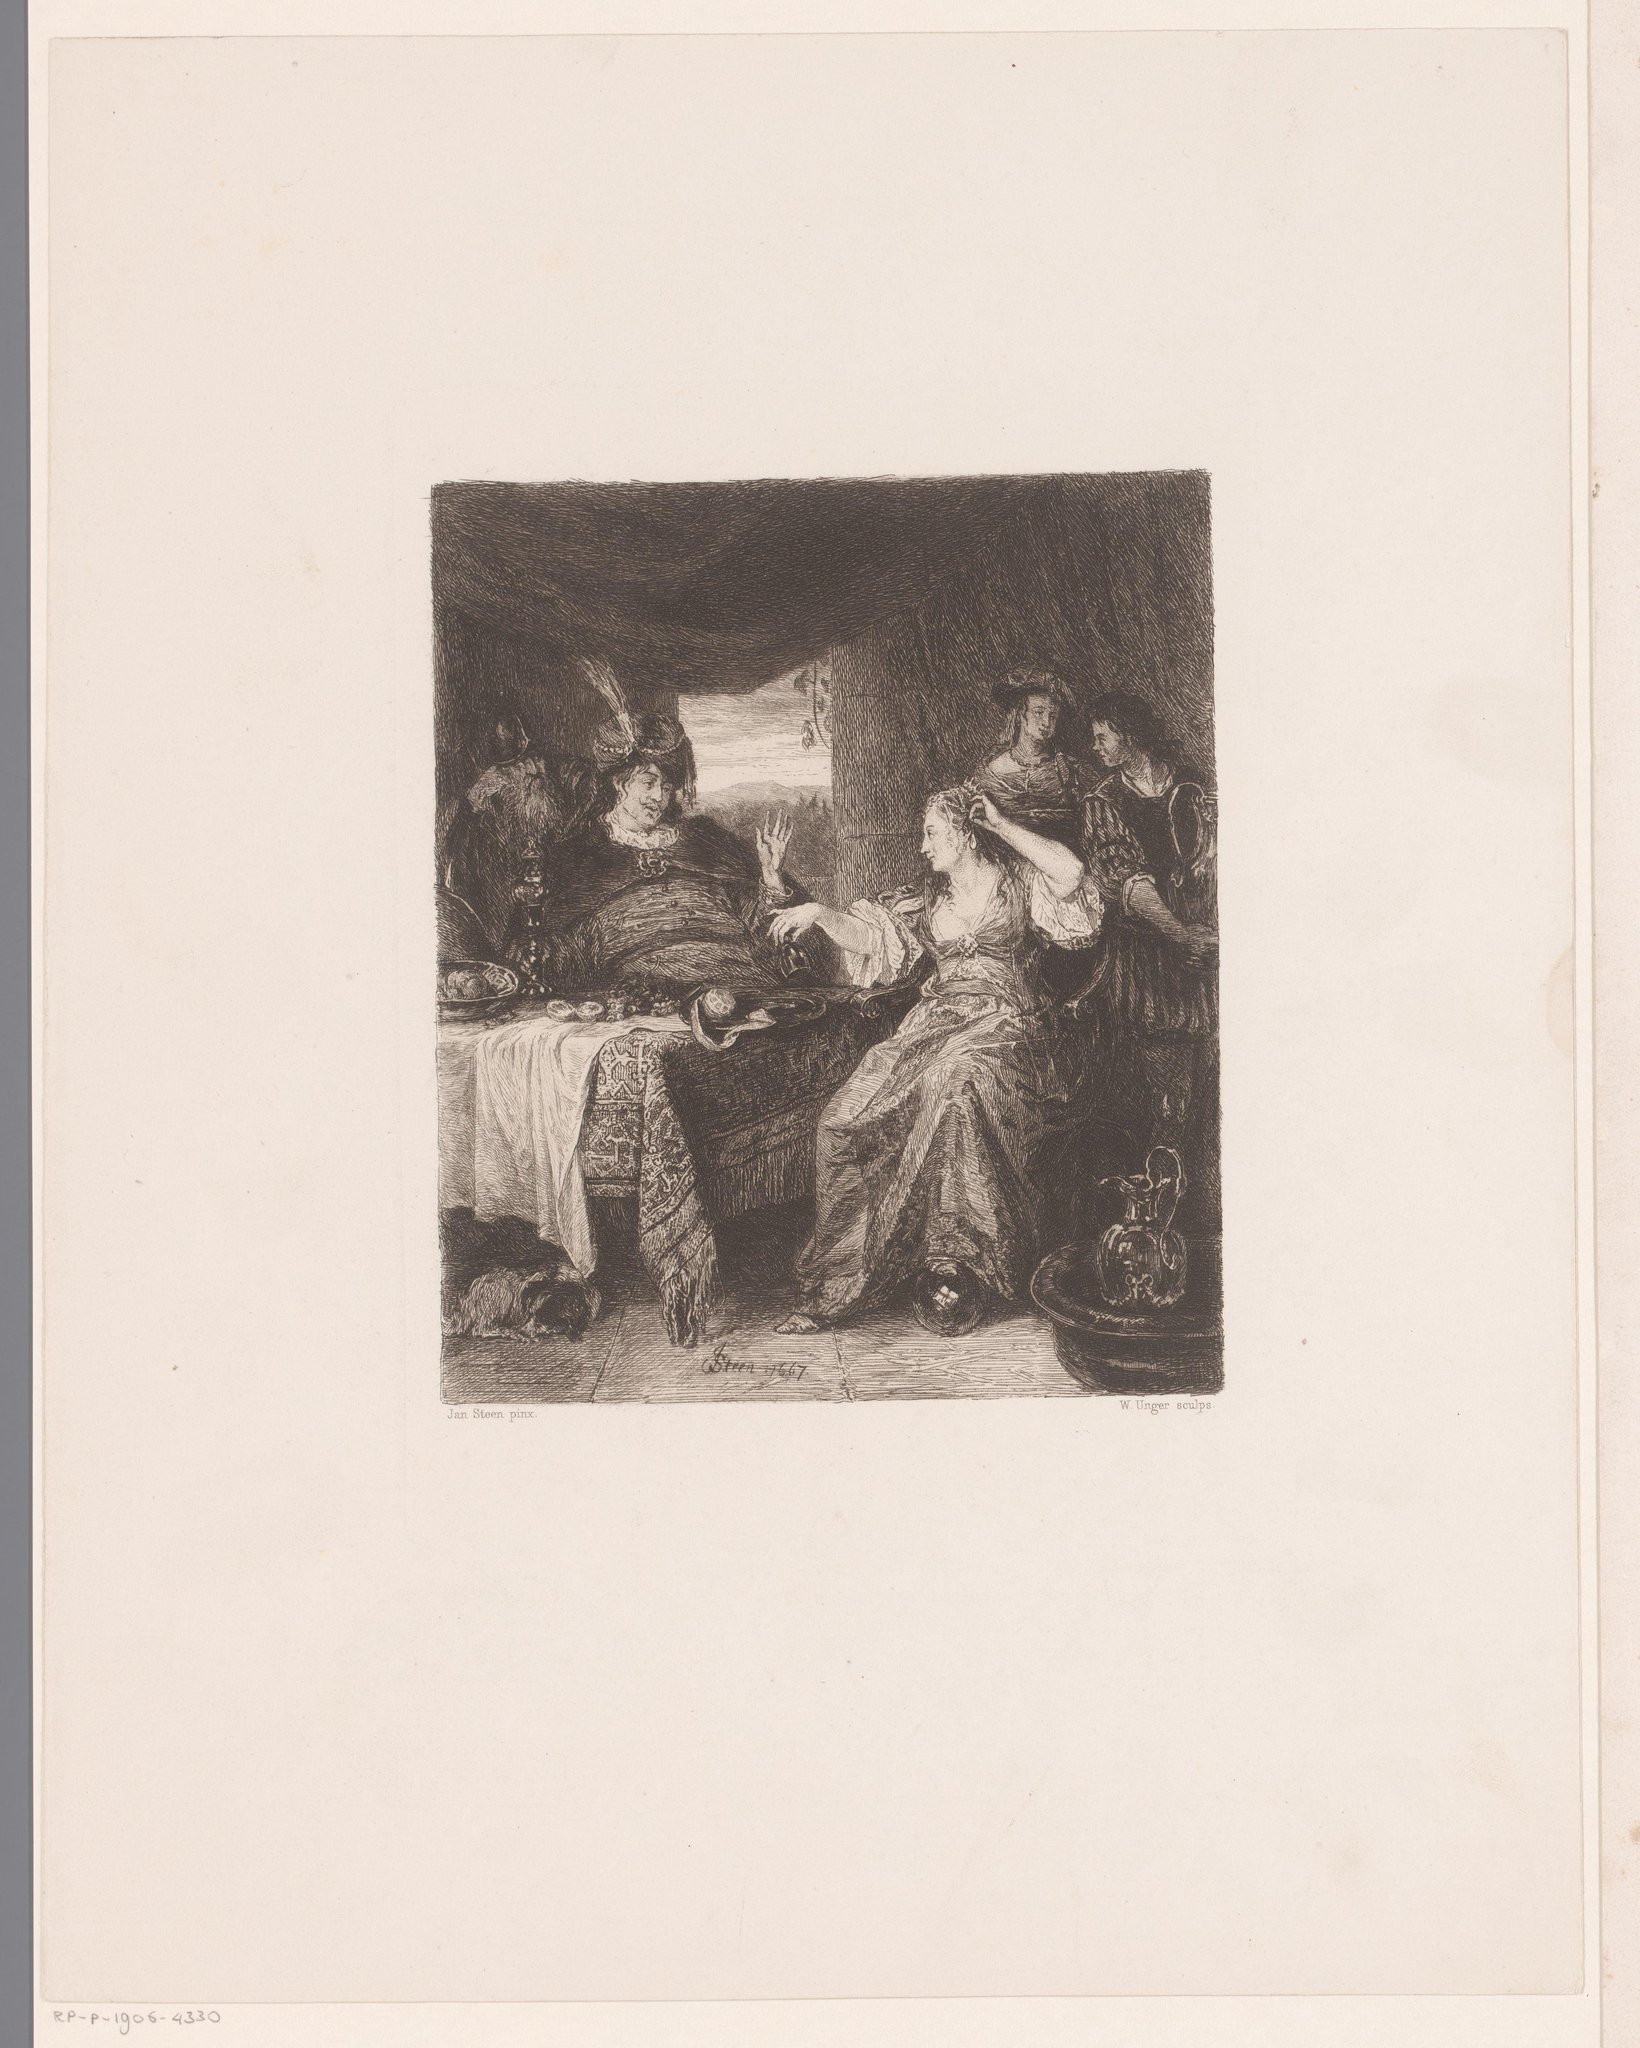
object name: print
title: Cleopatra's banket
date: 1847-1889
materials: paper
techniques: etching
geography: germany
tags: banquet of mark antony and cleopatra: she dissolves a pearl in a cup of wine, which she then drinks, celebration meal, feast, banquet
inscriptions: collector's mark: Lugt 2228